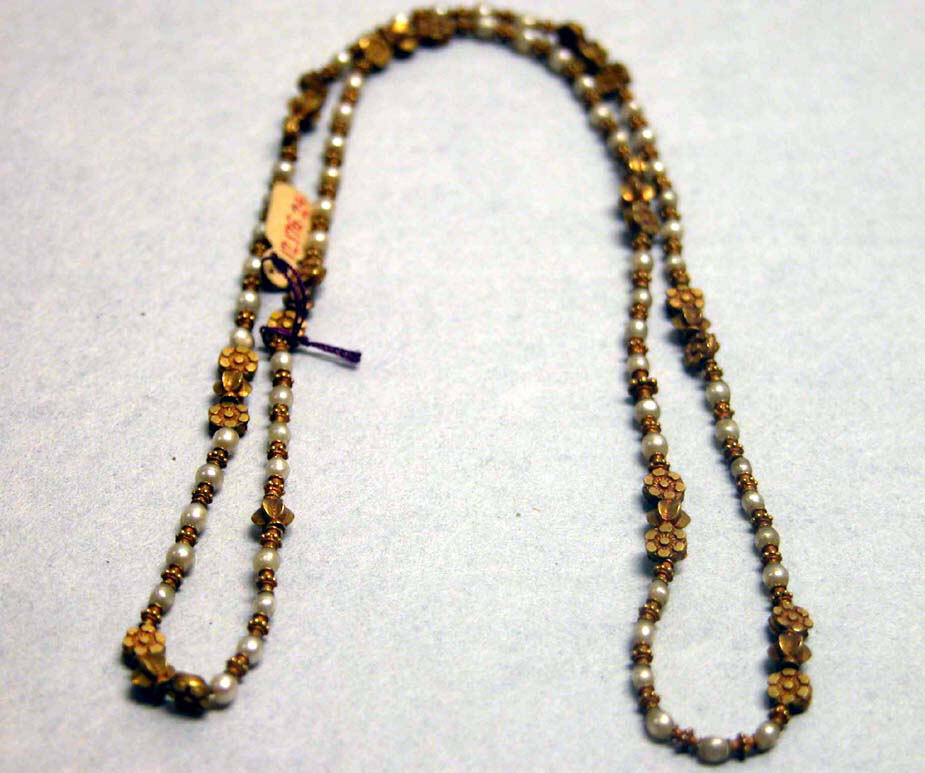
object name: rosary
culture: filipino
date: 1601-1900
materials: gold, pearl